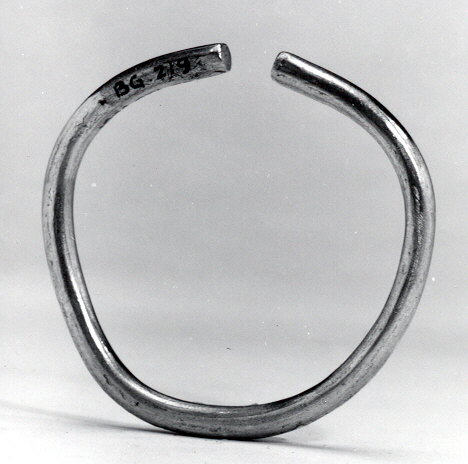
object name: nose ornament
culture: colombian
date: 901-1600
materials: gold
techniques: hammering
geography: colombia